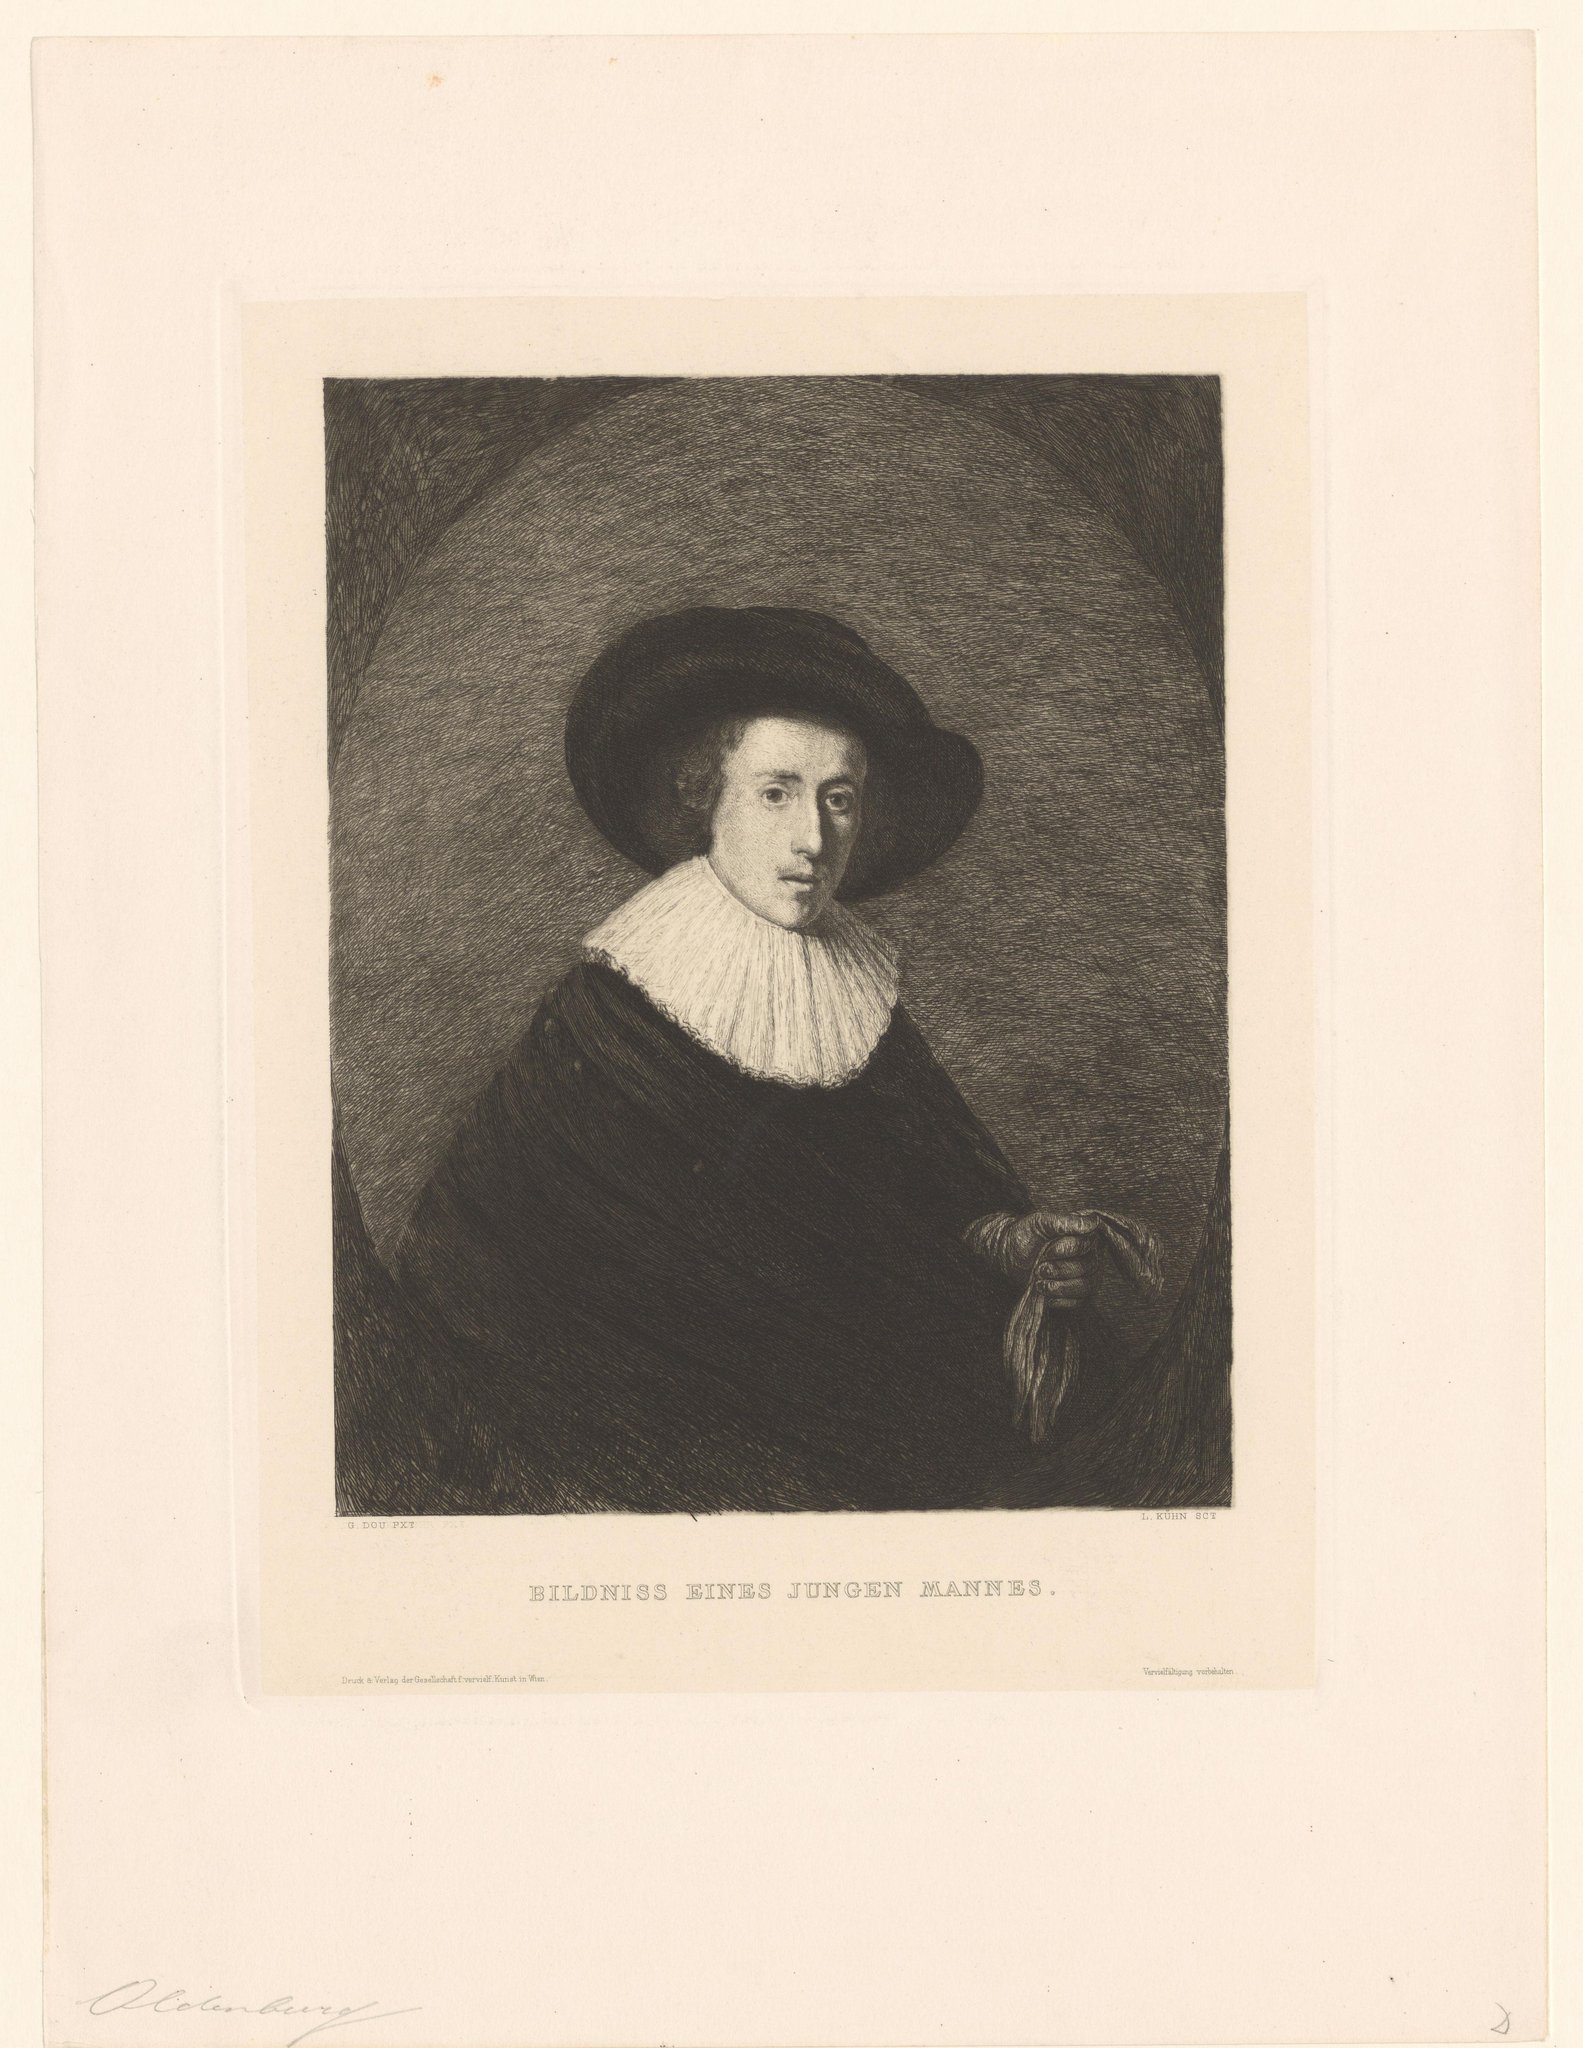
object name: print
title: Bildniss eines jungen Mannes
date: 1871-1934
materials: paper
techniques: engraving, etching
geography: vienna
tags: gloves, mittens, etc., anonymous historical person portrayed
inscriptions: collector's mark: Lugt 2228